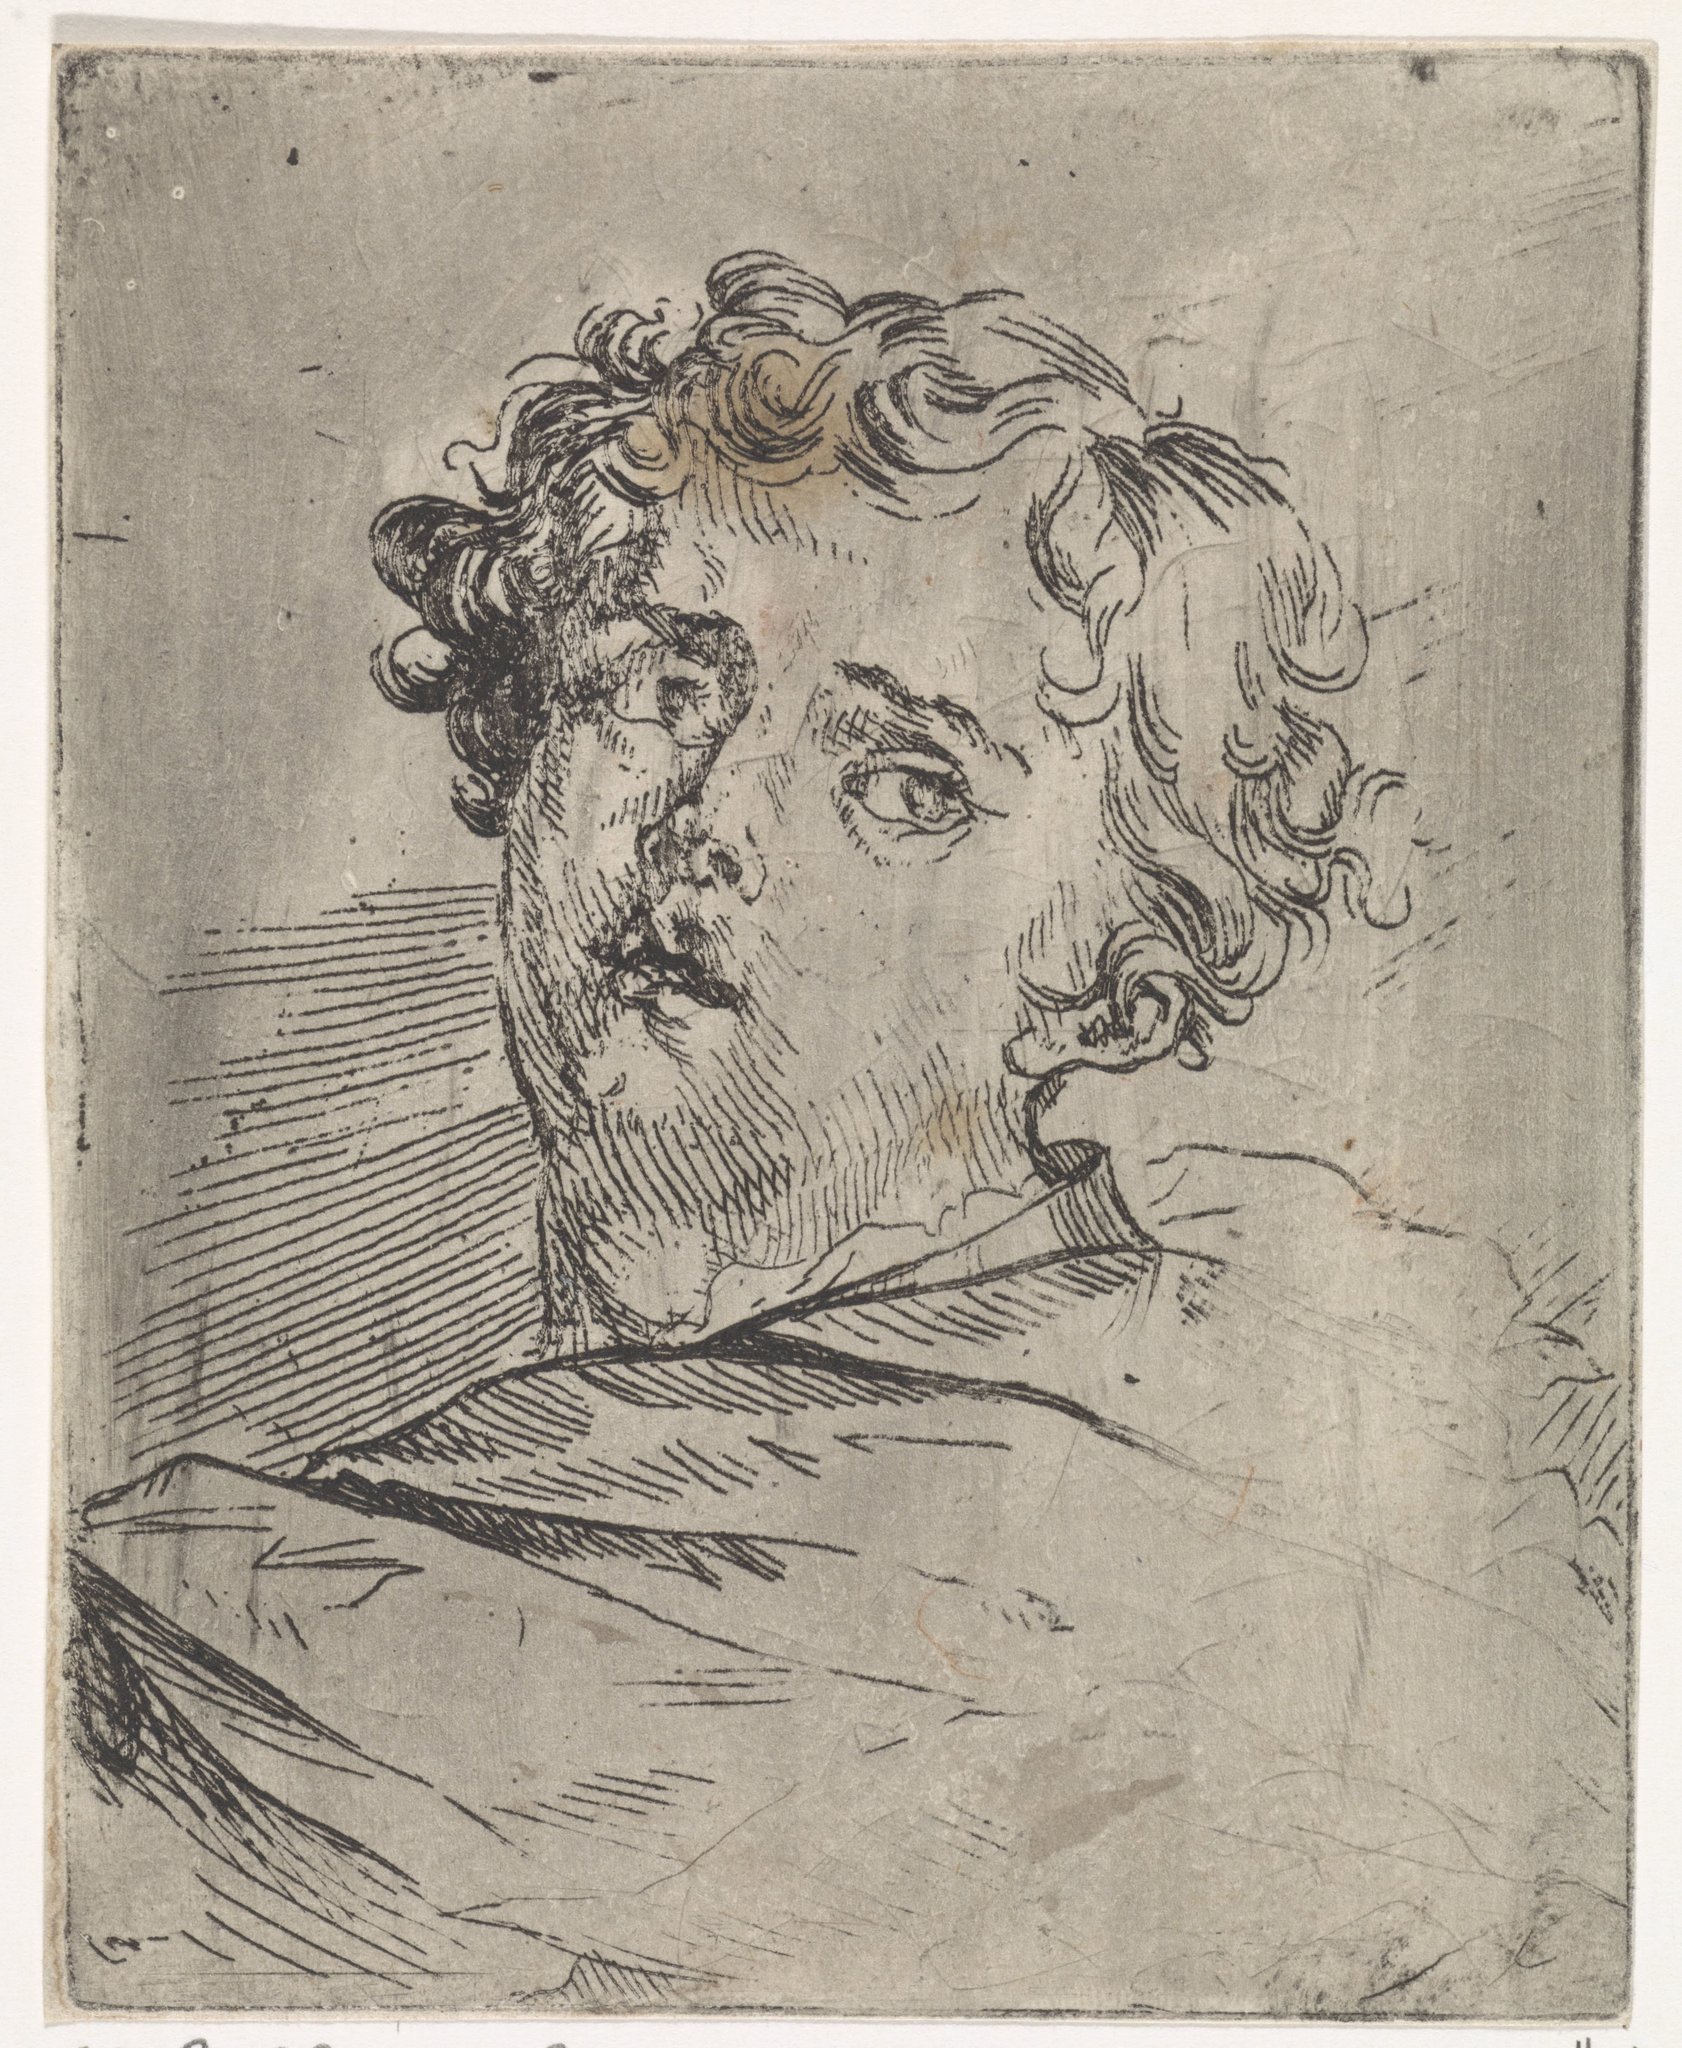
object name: print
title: Kop van een jongen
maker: carel de moor (ii)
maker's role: draughtsman, painter, print maker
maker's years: 1655-1738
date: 1665-1738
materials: paper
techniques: etching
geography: netherlands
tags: youth, adolescent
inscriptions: collector's mark: Lugt 240